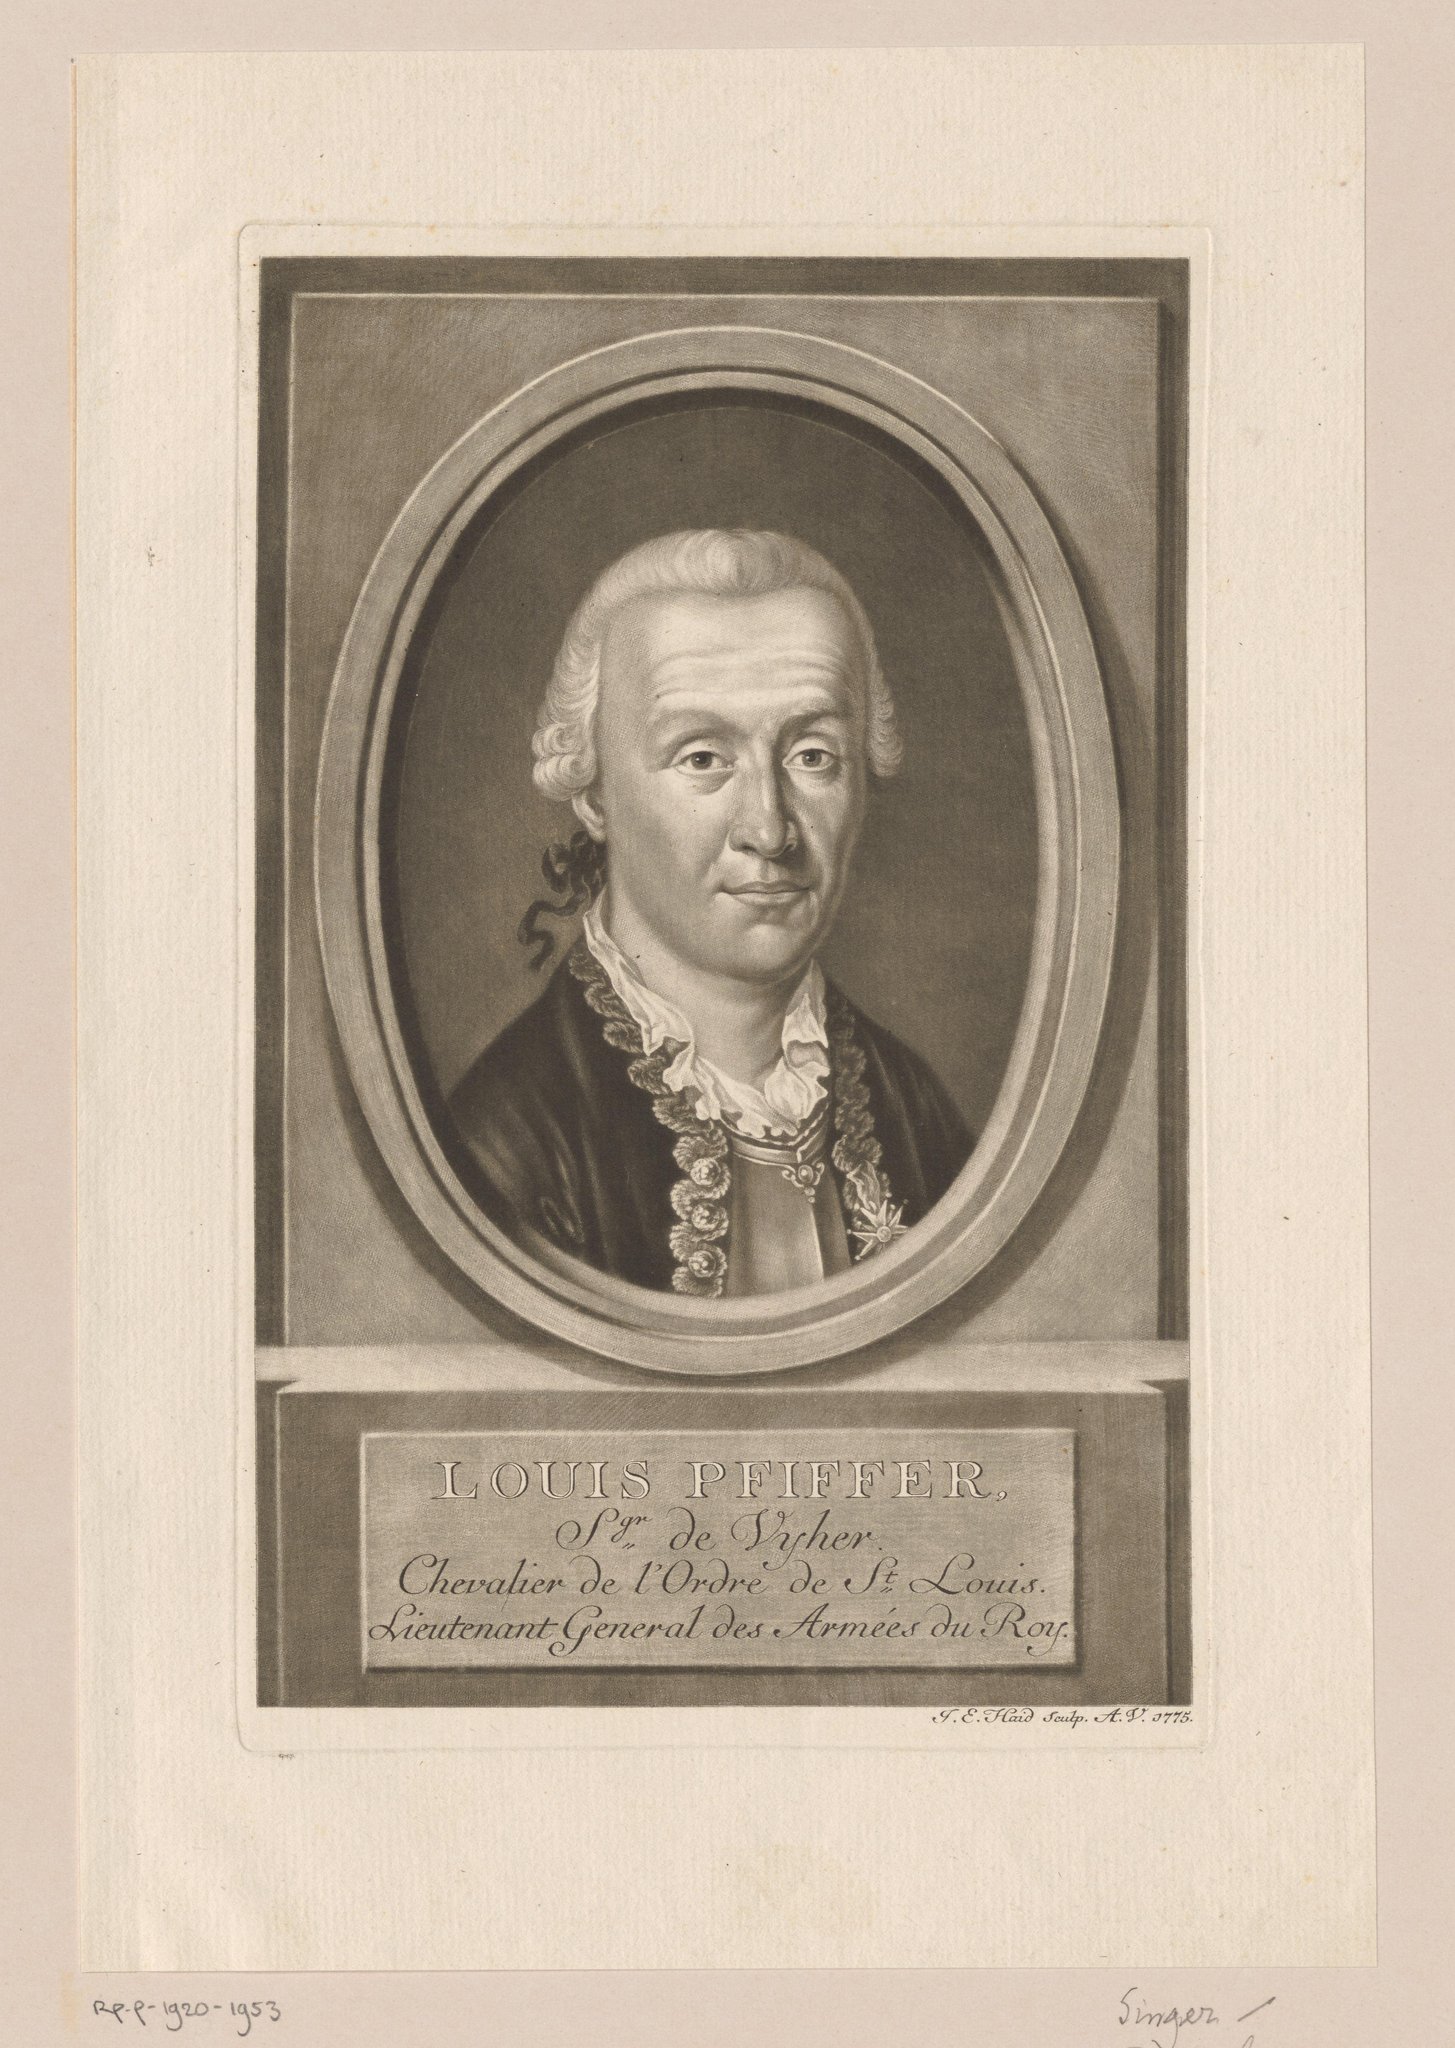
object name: print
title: Portret van Louis Pfiffer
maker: johann elias haid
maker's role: print maker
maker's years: 1739-1809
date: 1775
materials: paper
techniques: mezzotint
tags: commander-in-chief, general, marshal, adult man, historical persons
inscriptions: collector's mark: Lugt 2228